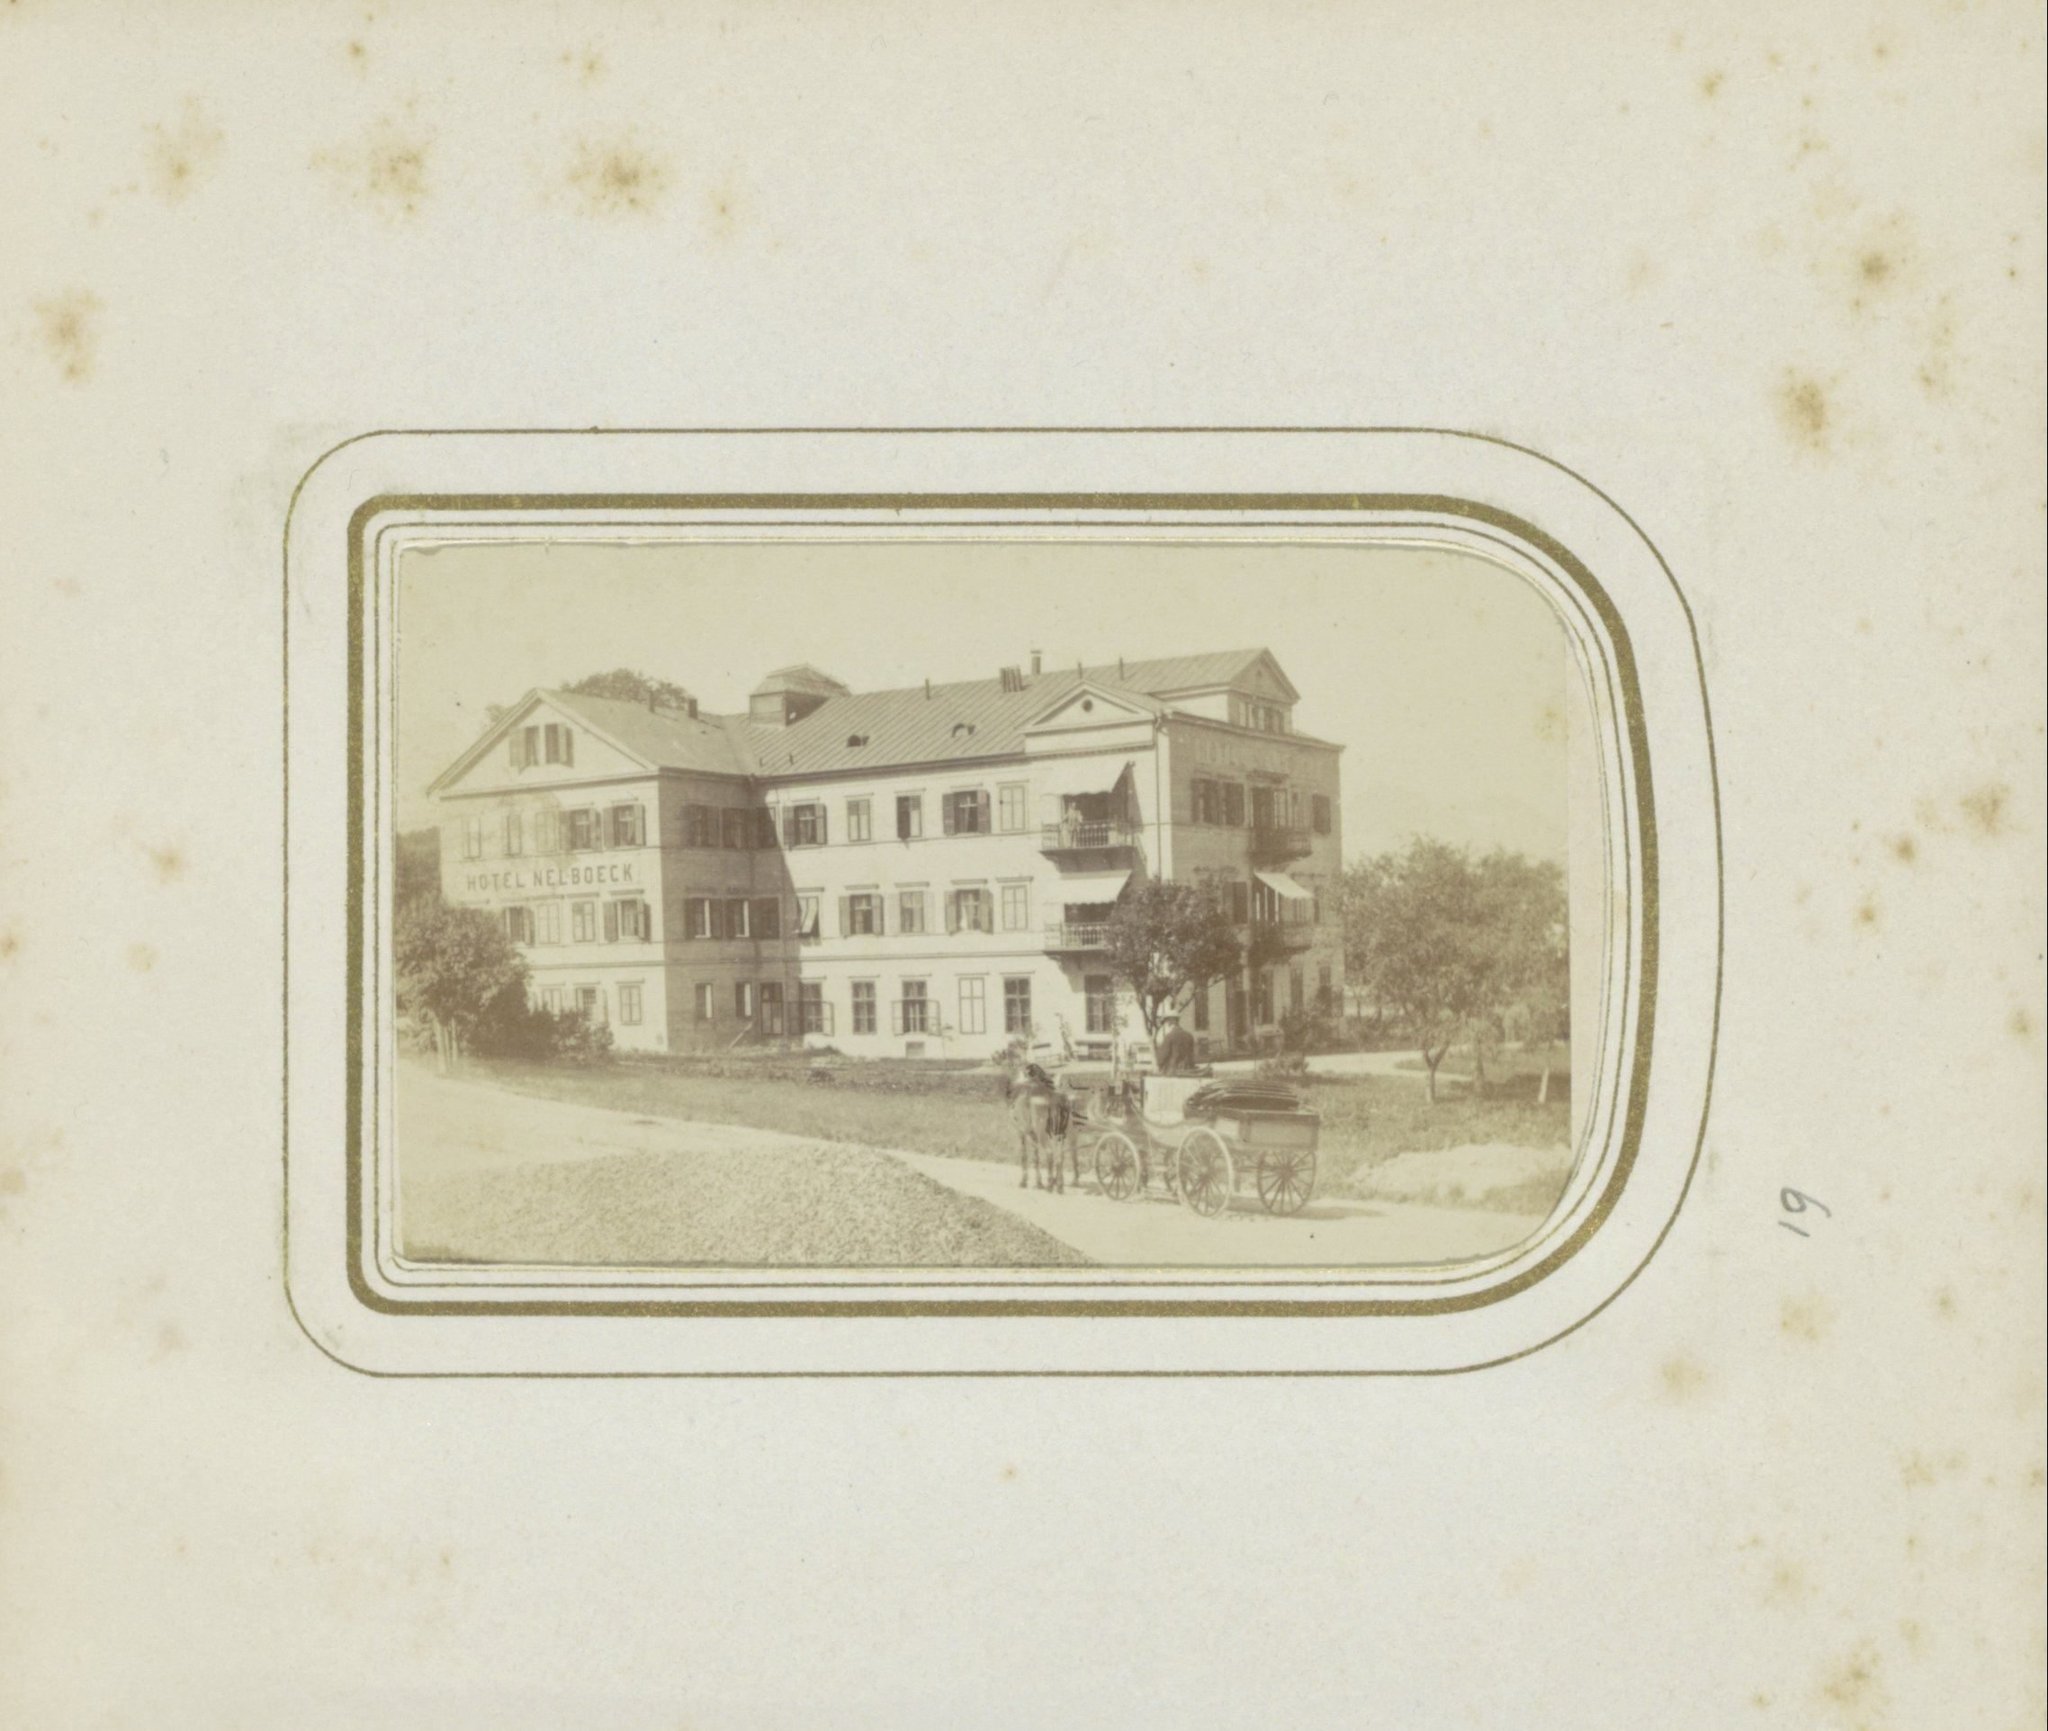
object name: photograph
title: Exterieur van Hotel Nelboeck in Salzburg met een paardenkoets ervoor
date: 1865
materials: paper, photographic support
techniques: albumen print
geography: drievuldigheidskerk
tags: four-wheeled, animal-drawn vehicle, e.g.: cab, carriage, coach (+ conveyance for transport of persons), river, waterfall, church (exterior), travelling; tourism, parts of church exterior and annexes: tower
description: Onderdeel van Fotoalbum van een reis door Zwitserland, Oostenrijk en Duitsland door de Nederlandse familie Derkinderen.